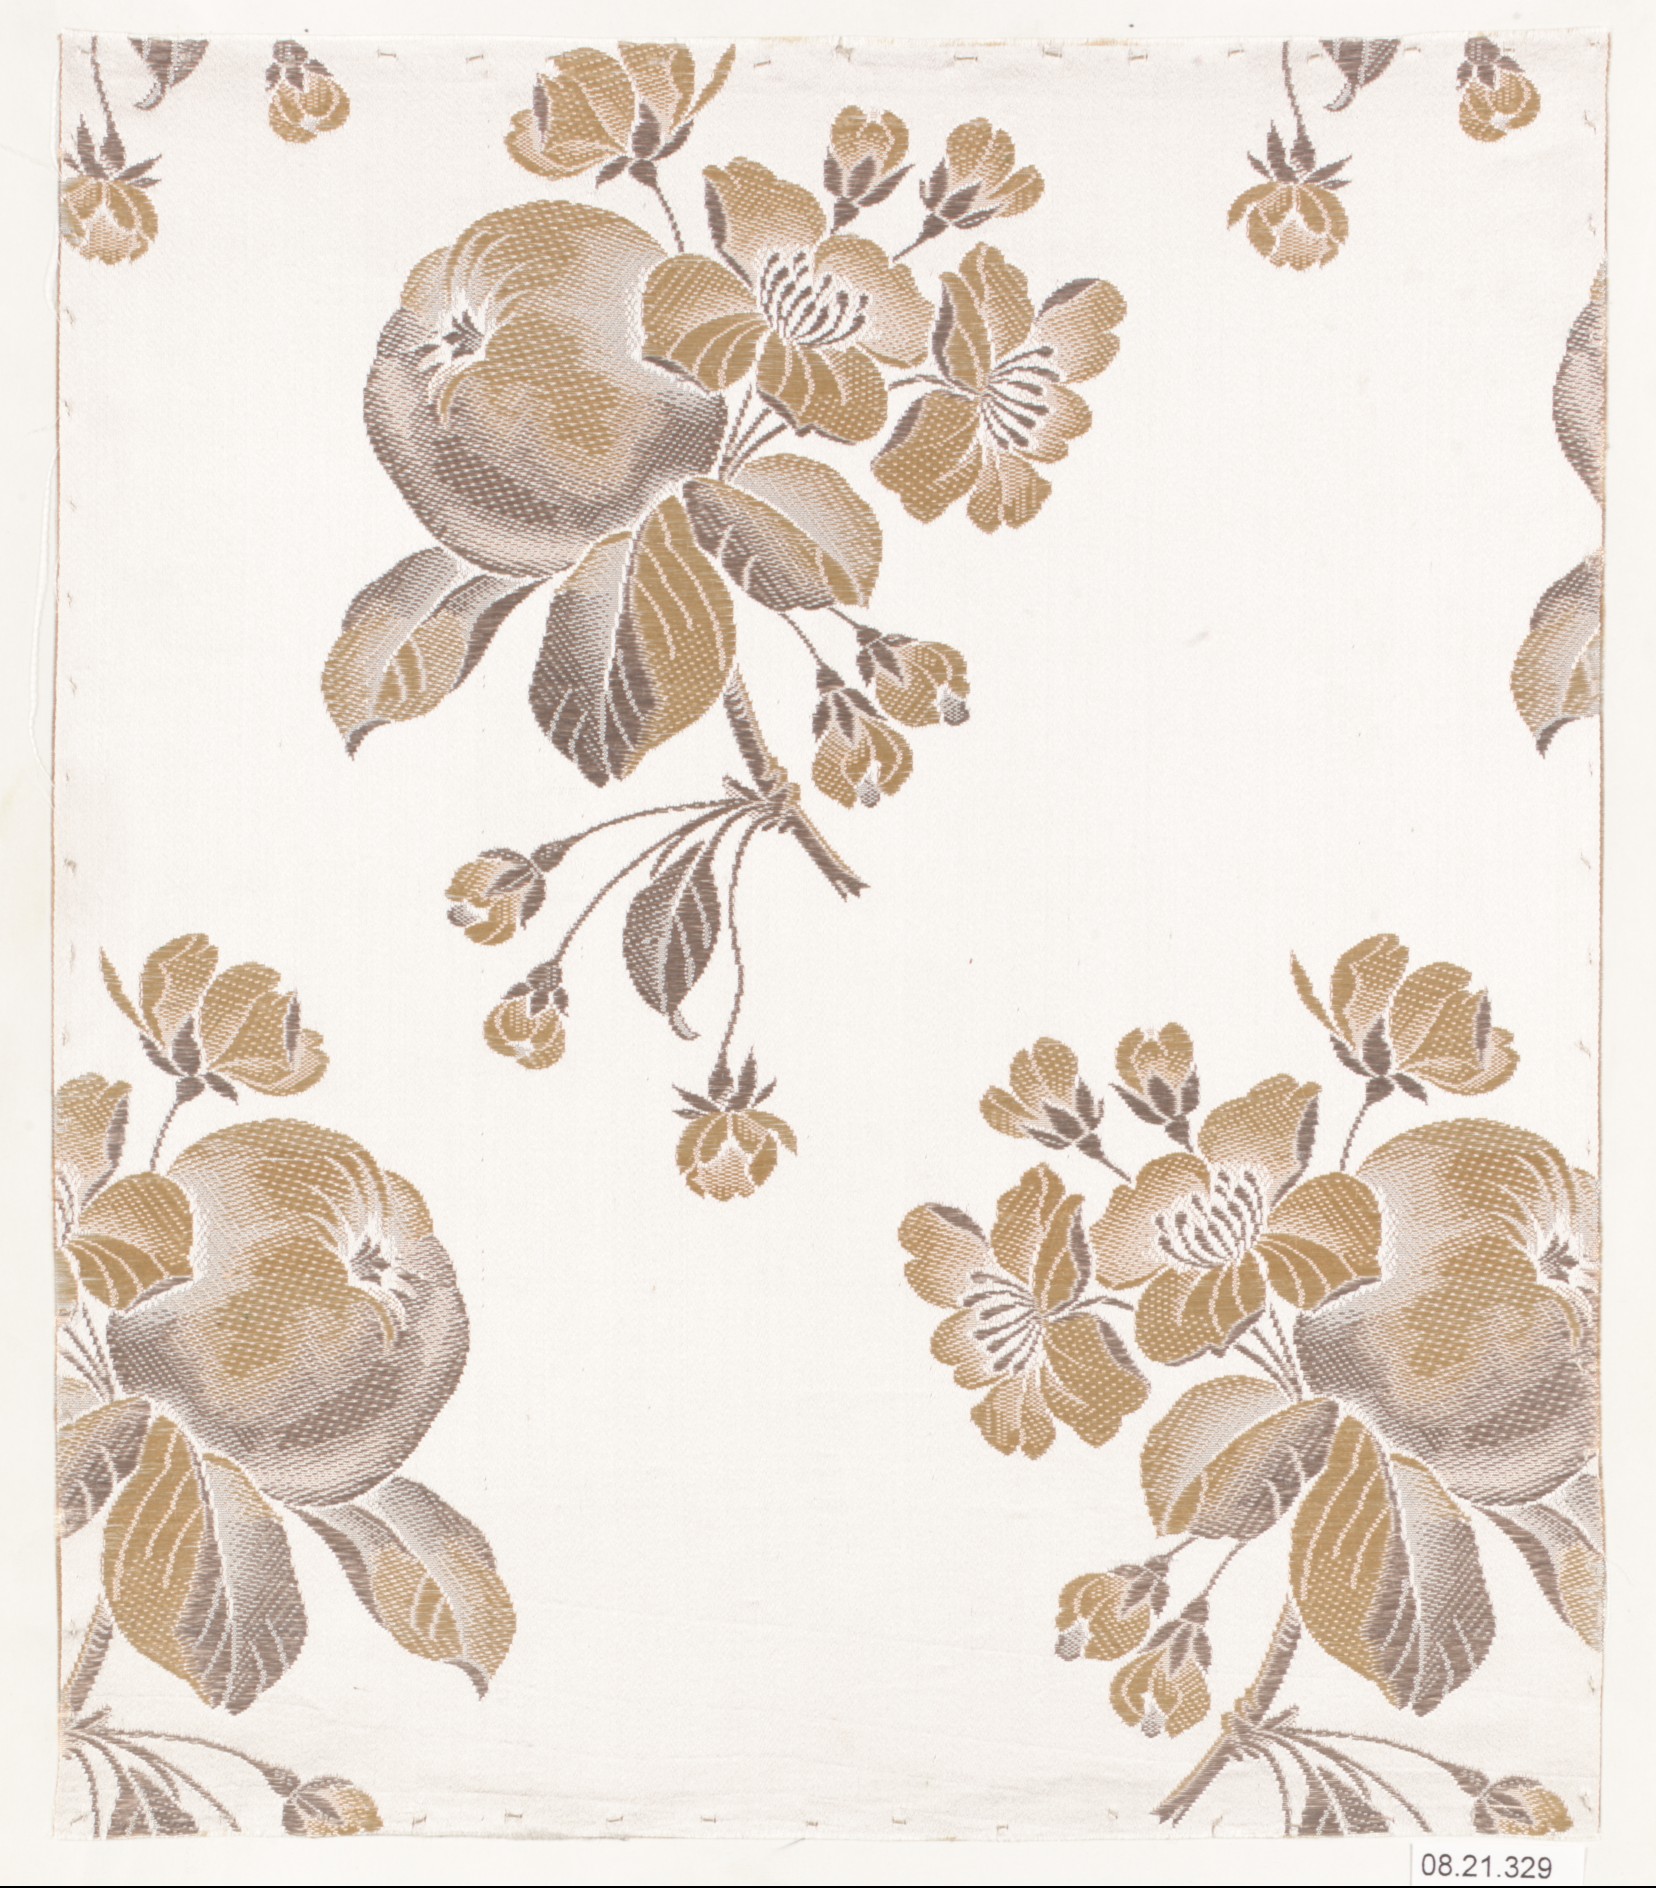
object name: textile sample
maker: Anonymous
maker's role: designer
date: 1900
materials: silk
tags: flowers